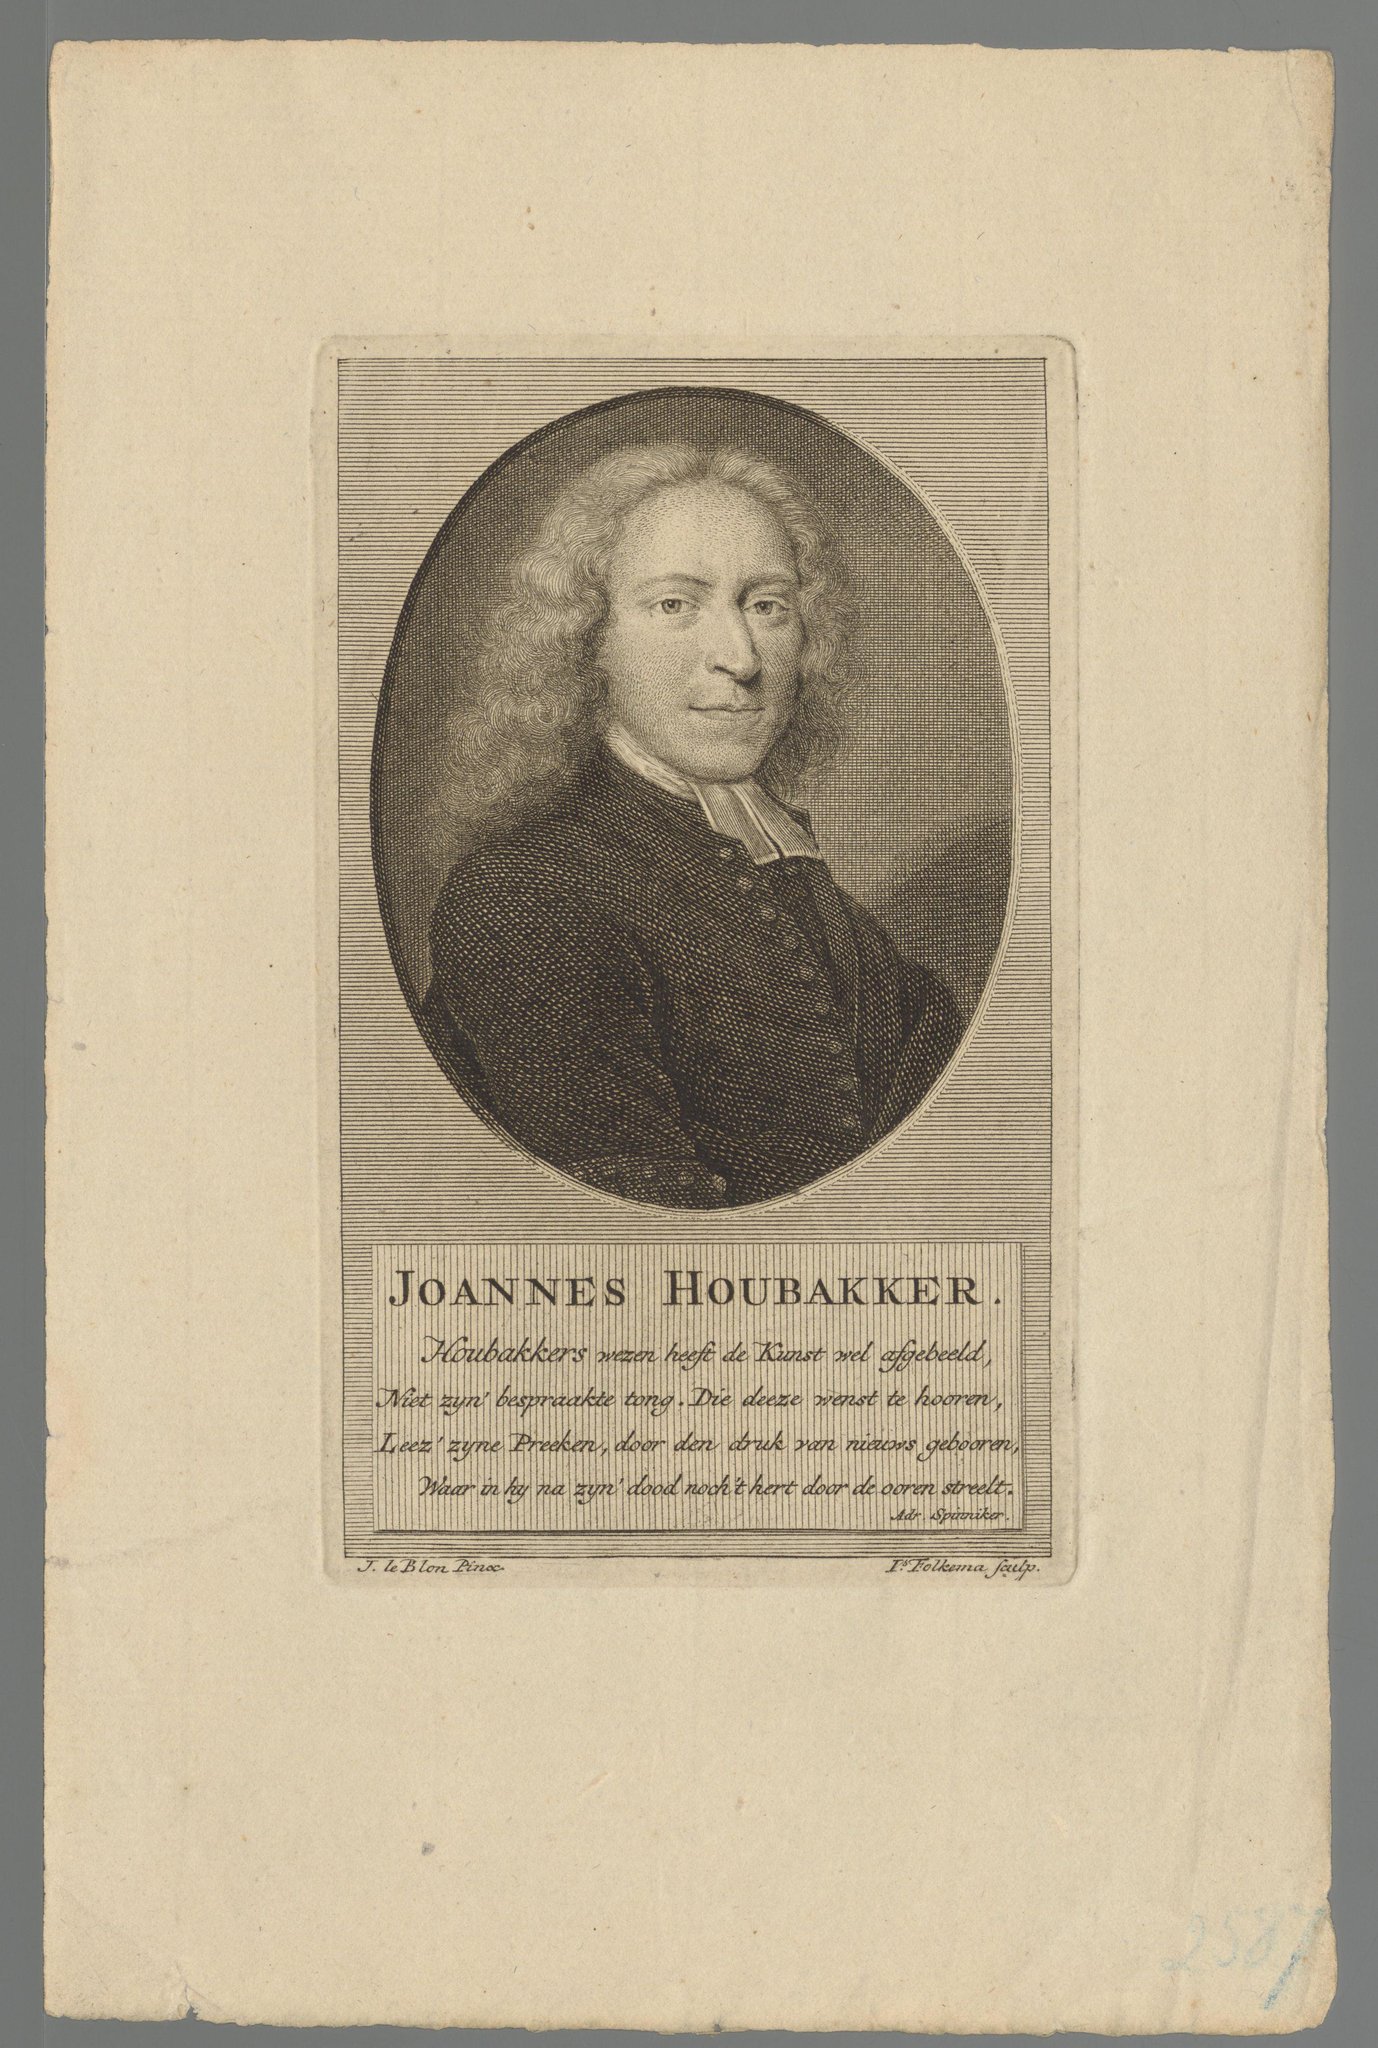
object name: book illustration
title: Portret van Joannes Houbakker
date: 1744-1745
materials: paper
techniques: engraving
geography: amsterdam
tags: amsterdam, historical persons, functionaries and dignitaries ~ episcopal protestant churches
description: Prent gebruikt in: Schijn, Hermannus. Uitvoeriger verhandeling van de Geschiedenisse der mennoniten. Amsterdam: Kornelis de Wit, 1744. Ook gebruikt in: Maatschoen, Gerardus. Aanhangzel, dienende tot een vervolg, of derde deel van de Geschiedenisse der mennoniten. Amsterdam: Kornelis de Wit, 1745.